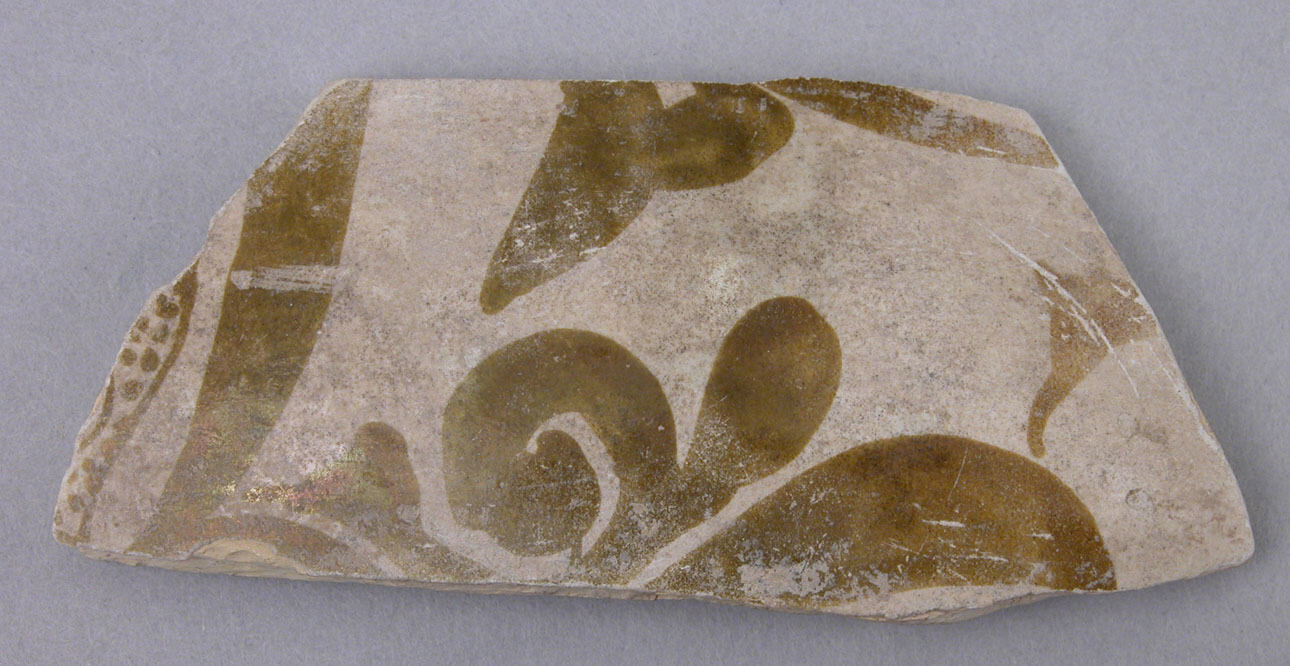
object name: fragment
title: Ceramic Fragment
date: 701-900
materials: earthenware, glaze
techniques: painting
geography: iraq